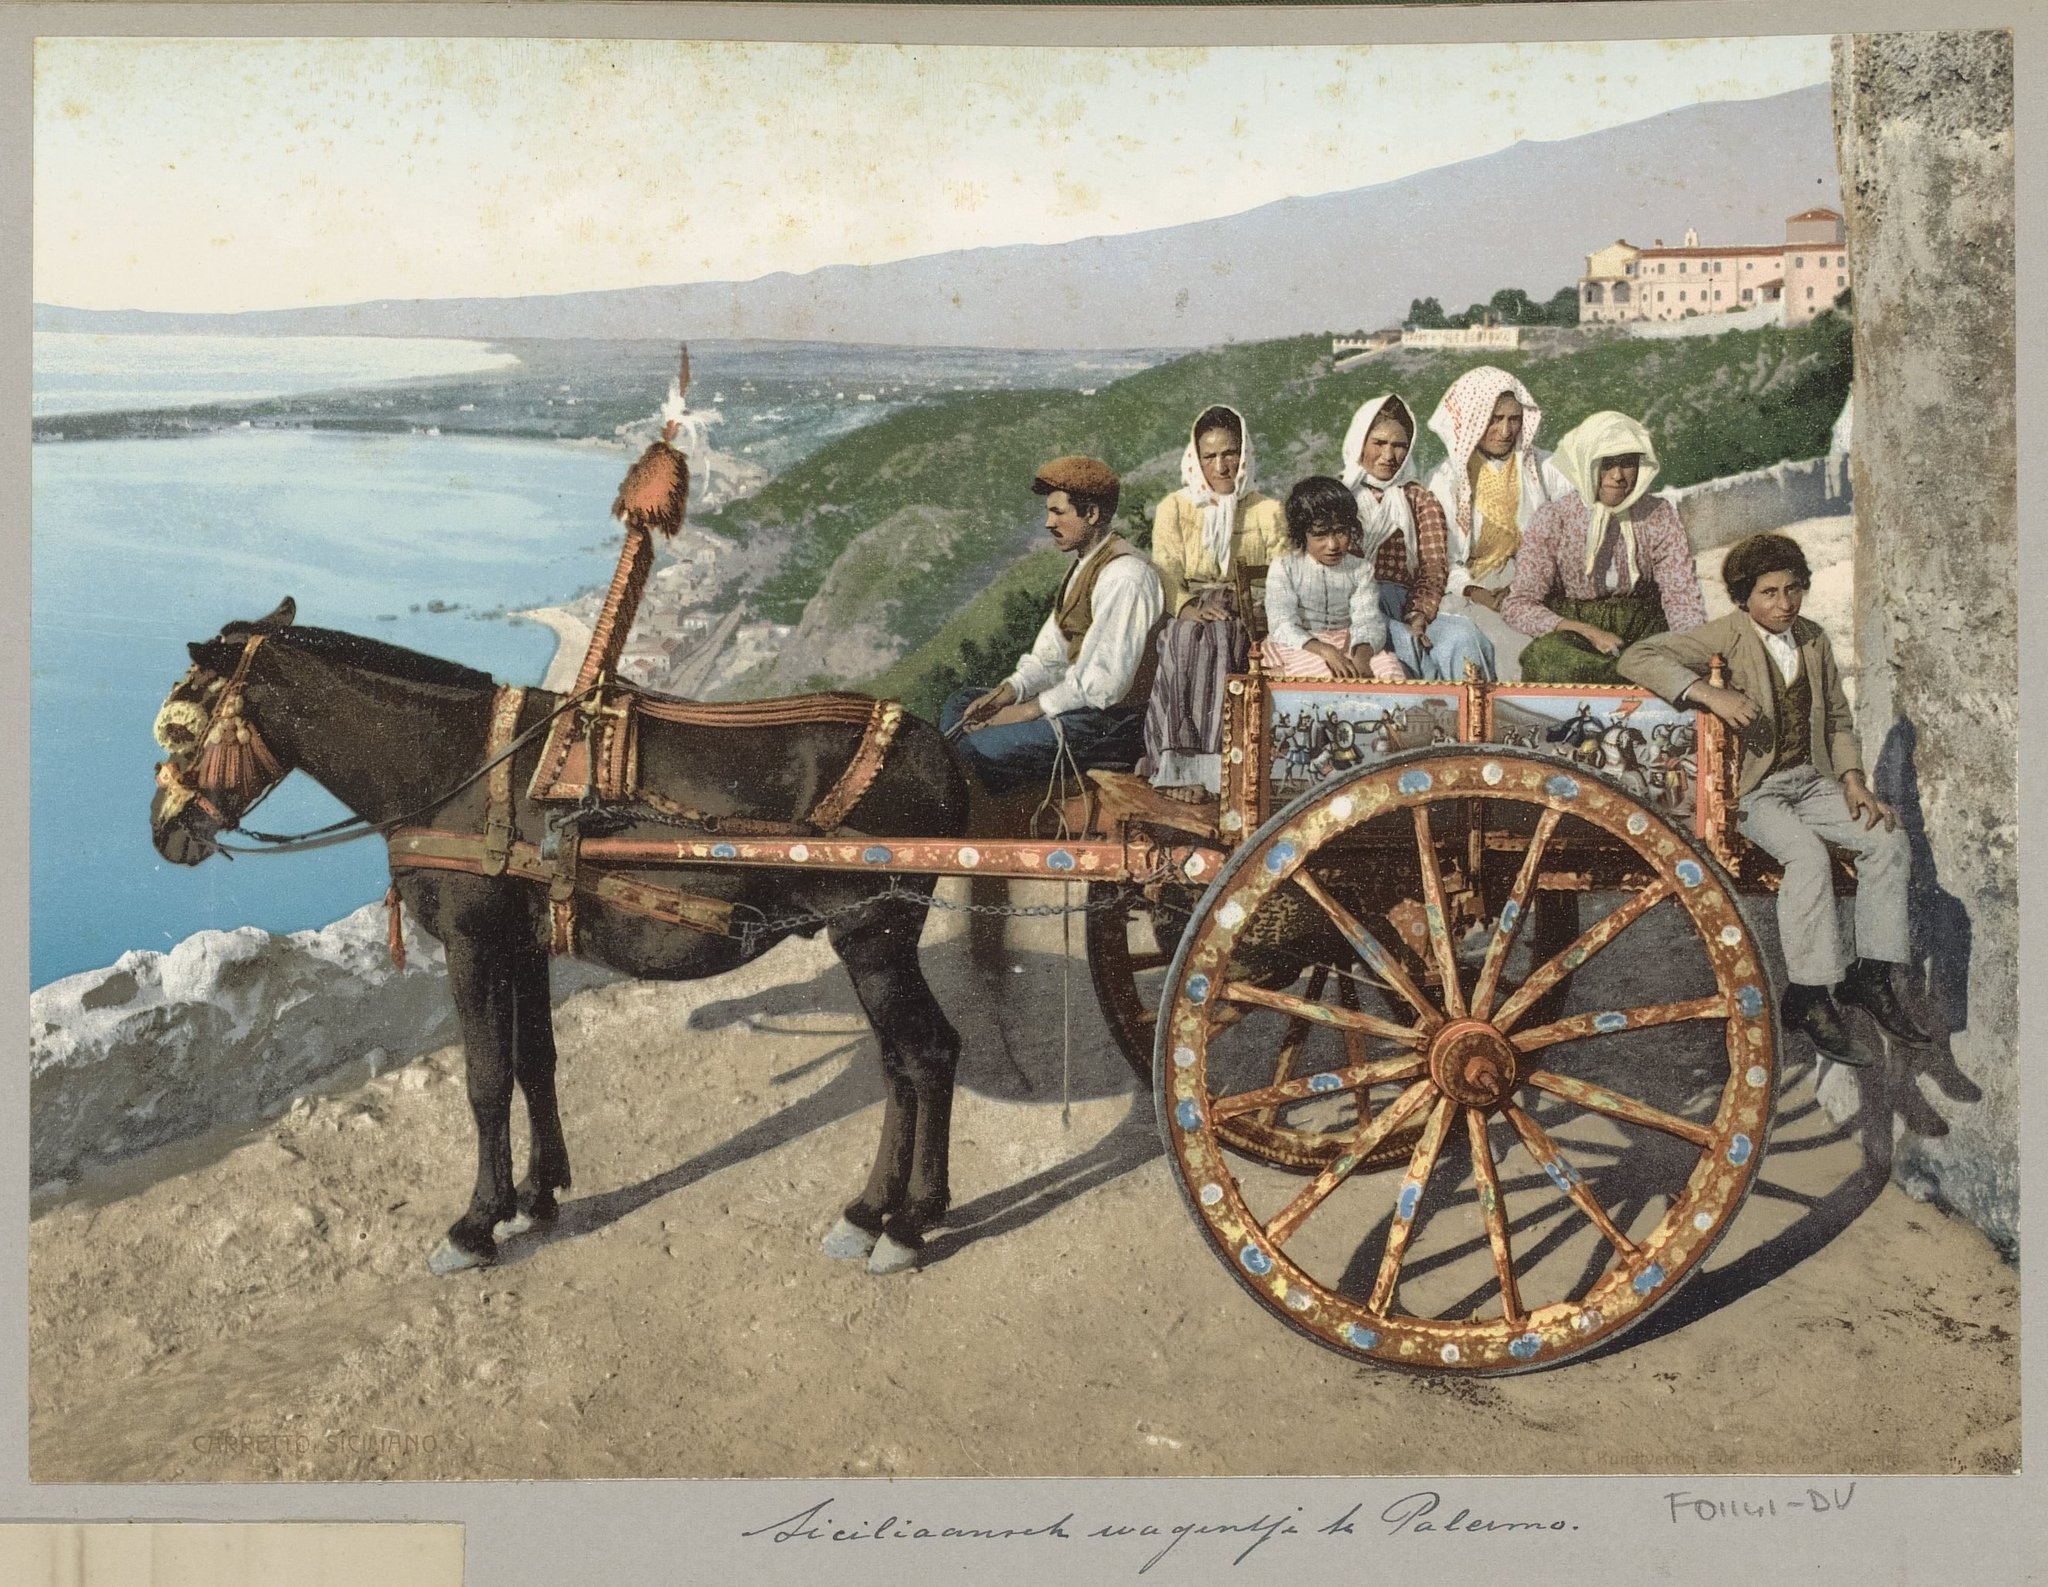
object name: print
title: Versierde paardenkar met boeren in Palermo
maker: Anonymous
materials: paper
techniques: hand coloring, lithograph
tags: two-wheeled, animal-drawn vehicle, farmers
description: Onderdeel van Fotoalbum van een reis door Zuid-Europa en het Midden-Oosten.